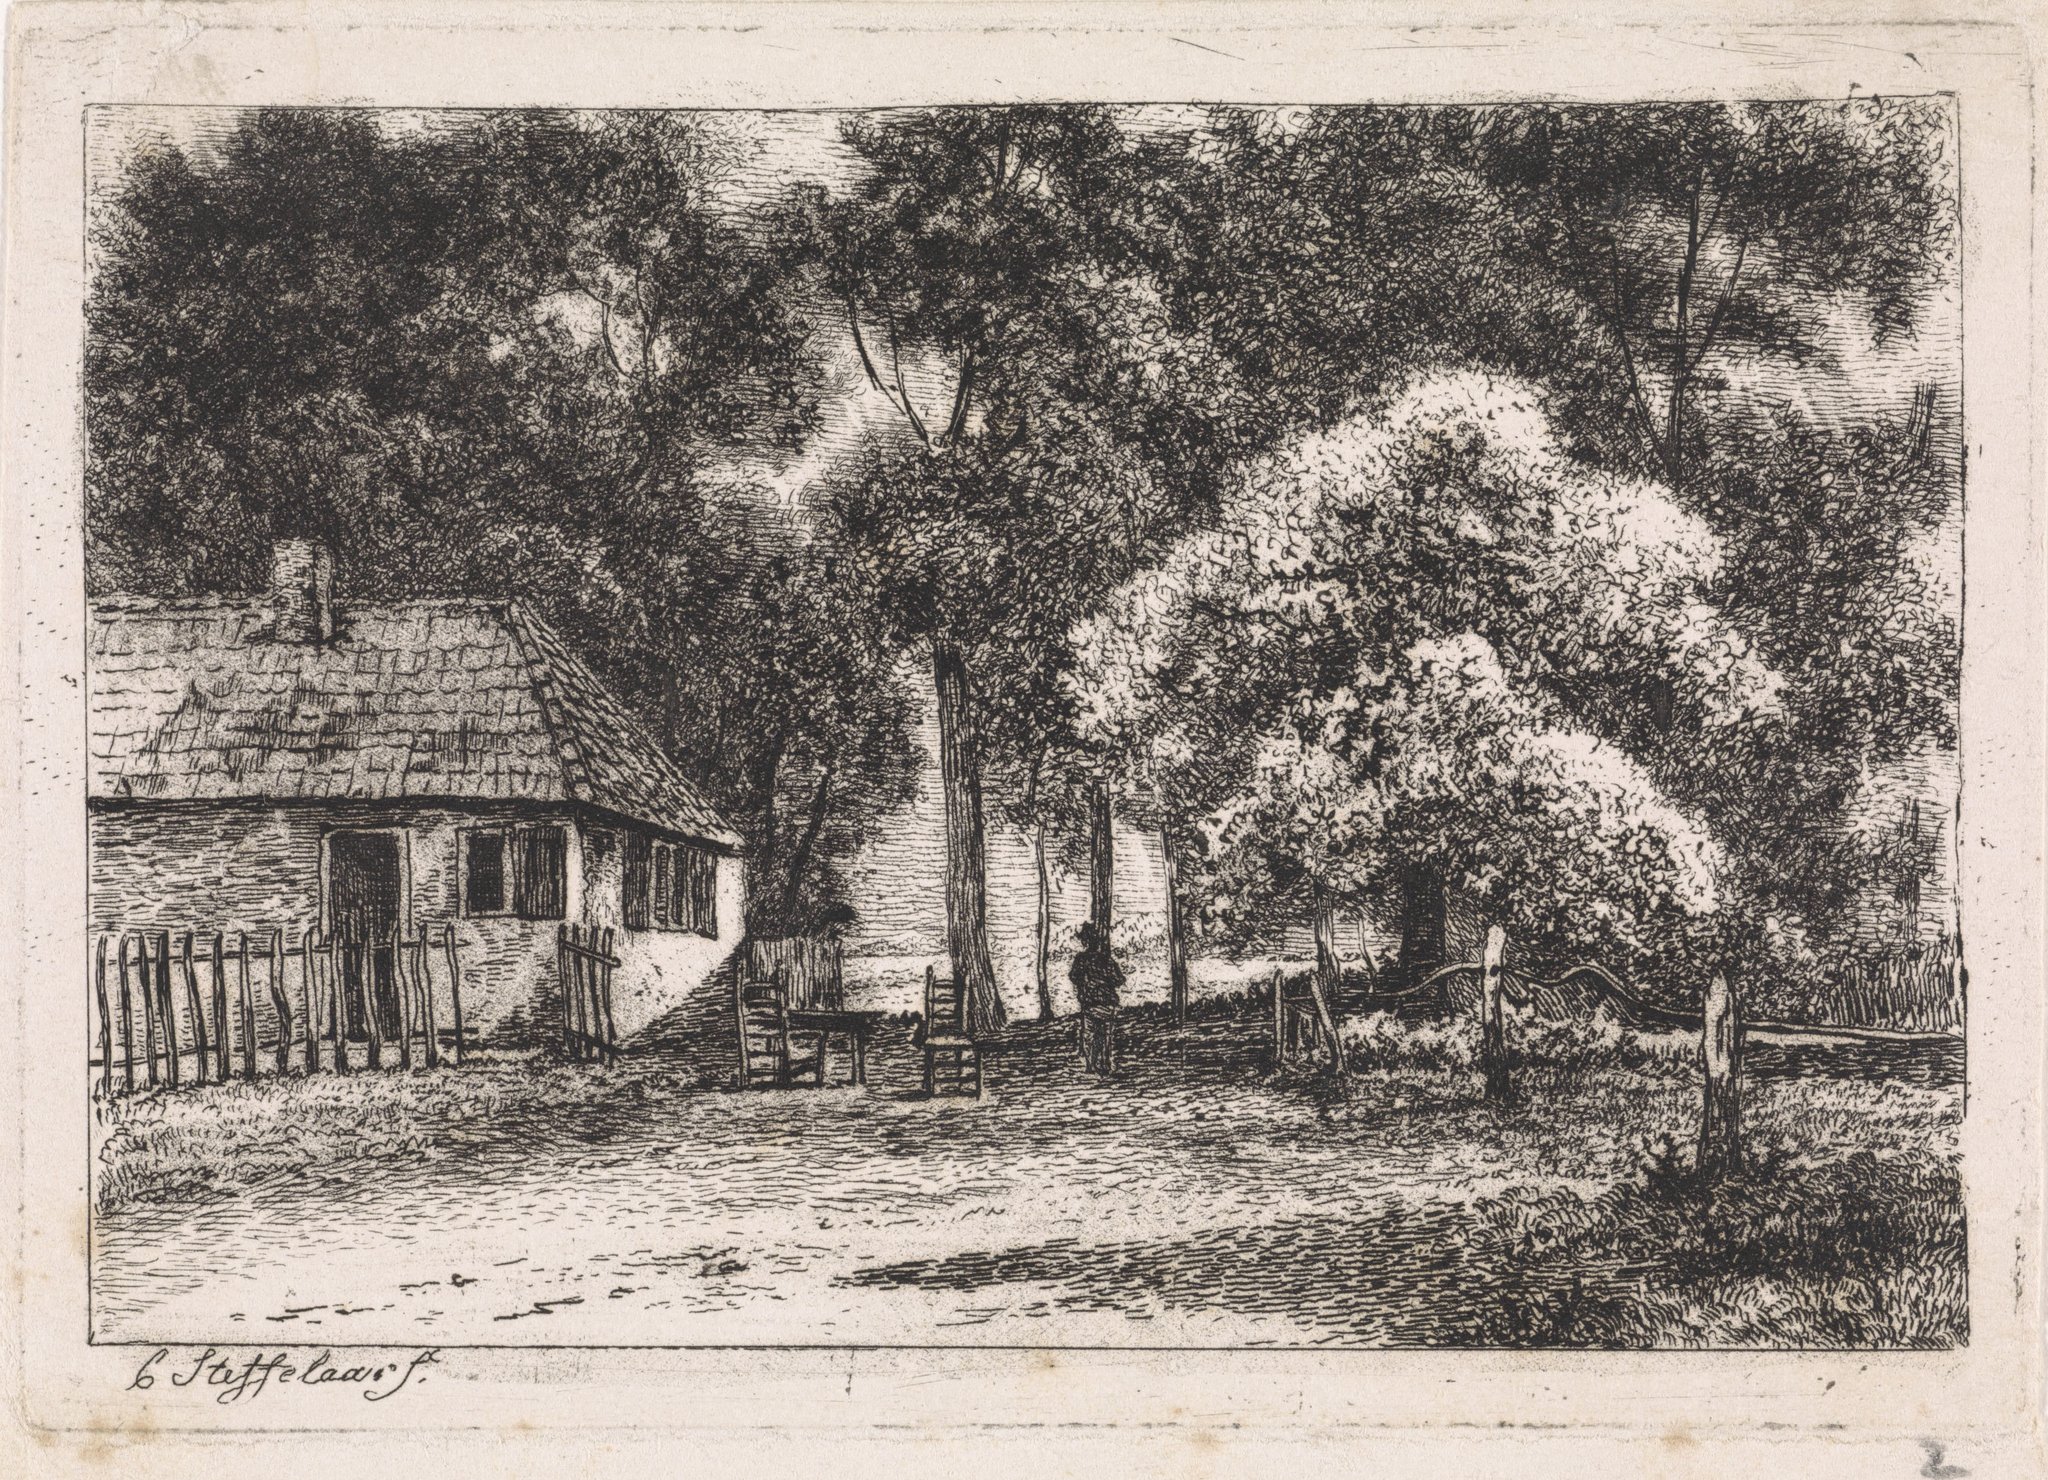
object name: print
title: Huis tussen geboomte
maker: cornelis steffelaar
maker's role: draughtsman, painter, print maker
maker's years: 1797-1861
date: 1807-1861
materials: paper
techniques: aquatint, etching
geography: amsterdam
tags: trees, farm or solitary house in landscape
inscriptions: collector's mark: Lugt 2228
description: Links een huis met een hek. Naast het huis twee stoelen bij een tafel en een man.